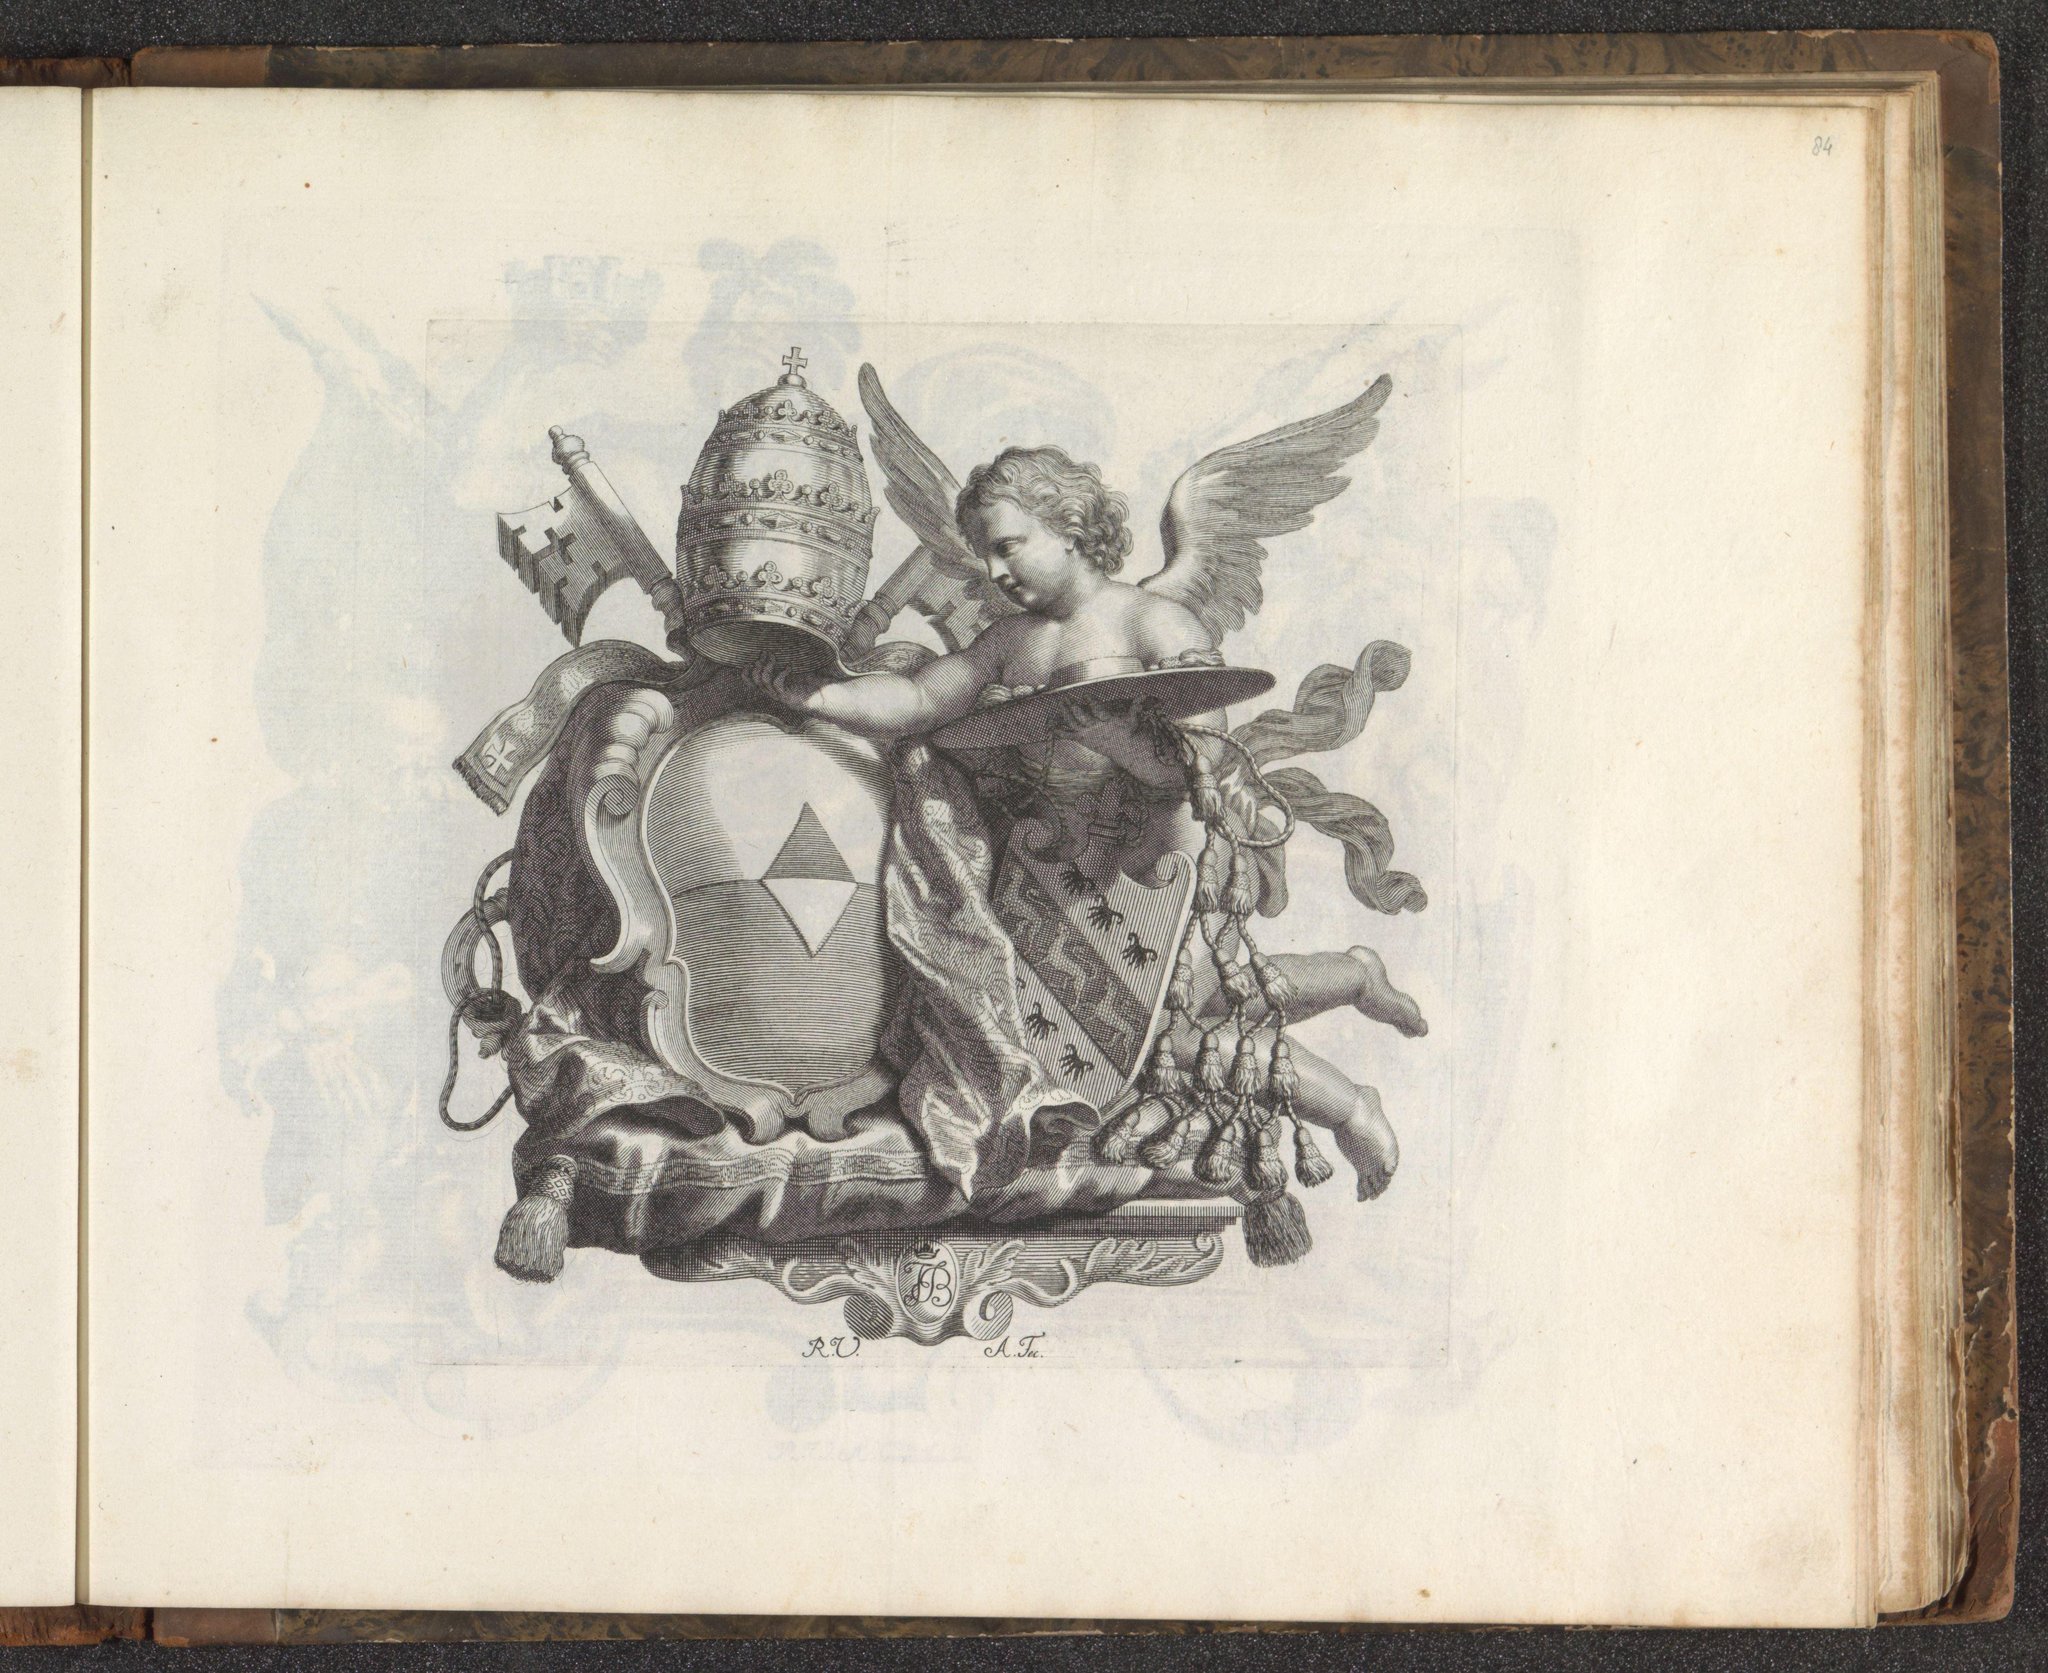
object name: album leaf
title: Engel met de wapenschilden van paus Gregorius XII en kardinaal Angelo Barbarigo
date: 1673-1743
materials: paper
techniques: engraving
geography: rome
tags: venice, clergyman, coat of arms (as symbol of the state, etc.), insignia of the pope, e.g. tiara, insignia of cardinal, e.g. hat, mantle, angels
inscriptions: collector's mark: Lugt 2228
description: Een console met het wapen van paus Gregorius XII en dat van Angelo Barbarigo, die door hem tot kardinaal werd benoemd. Een engel houdt er een tiara en kardinaalshoed boven. De prent maakt deel uit van een album.